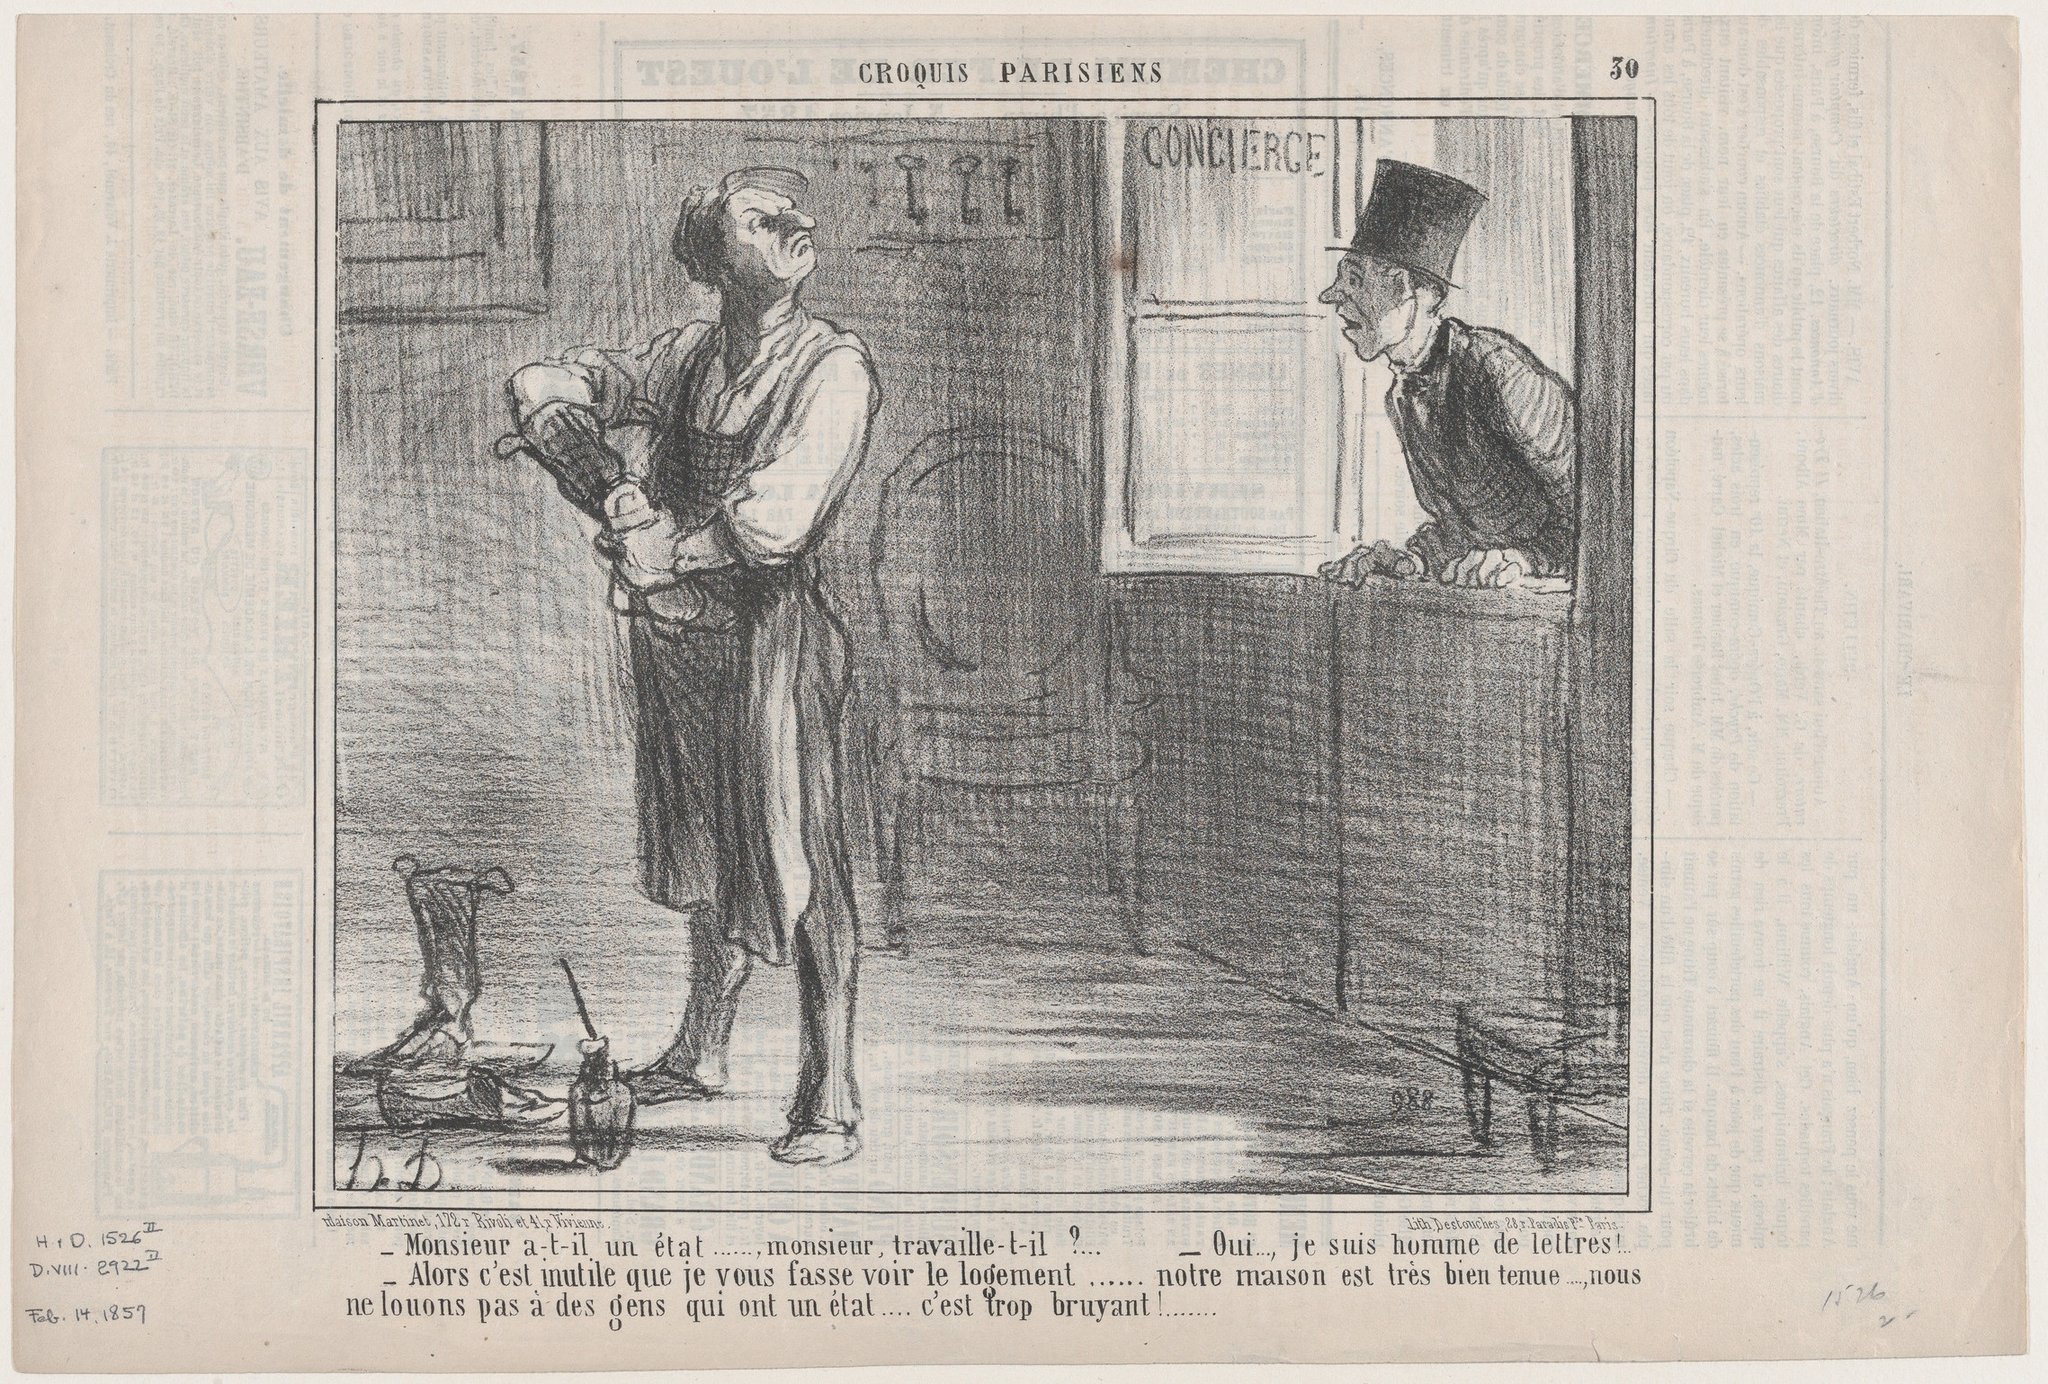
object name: print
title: Monsieur a-t-il un état..., from "Croquis Parisiens"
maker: honoré daumier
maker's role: artist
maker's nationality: french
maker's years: 1808-1879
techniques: lithograph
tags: satire,men